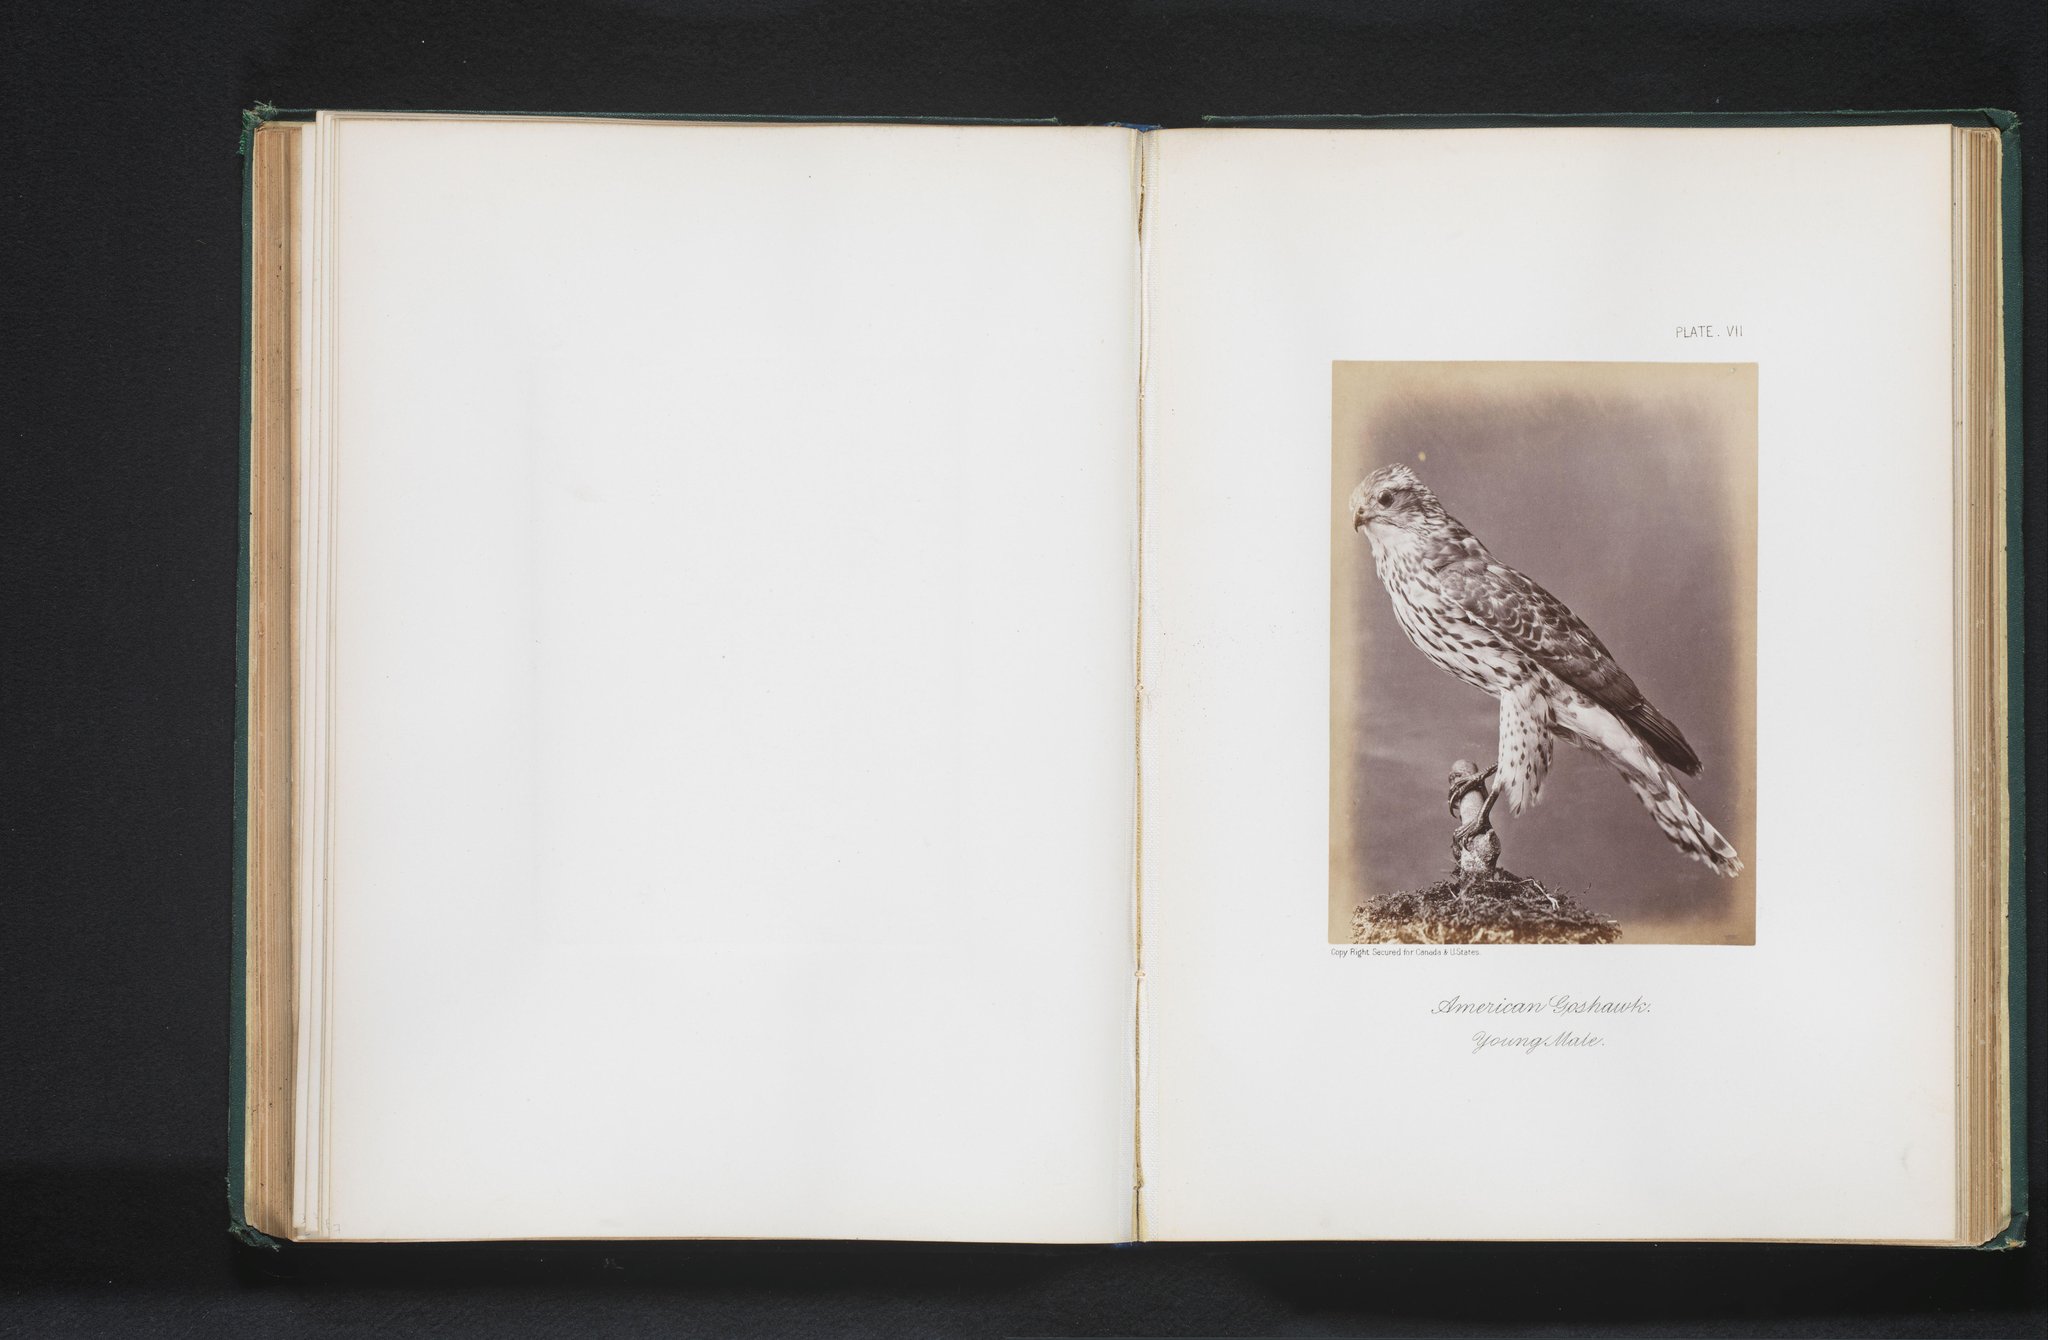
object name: photograph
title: American Goshawk. Adult Male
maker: william notman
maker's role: fotograaf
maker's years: 1826-1891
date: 1871-1876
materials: paper, photographic support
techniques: albumen print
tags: collection of animals, predatory birds: hawk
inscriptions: number: ‘PLATE VII’, inscription: ‘Copy Right Secured for Canada & U.States’